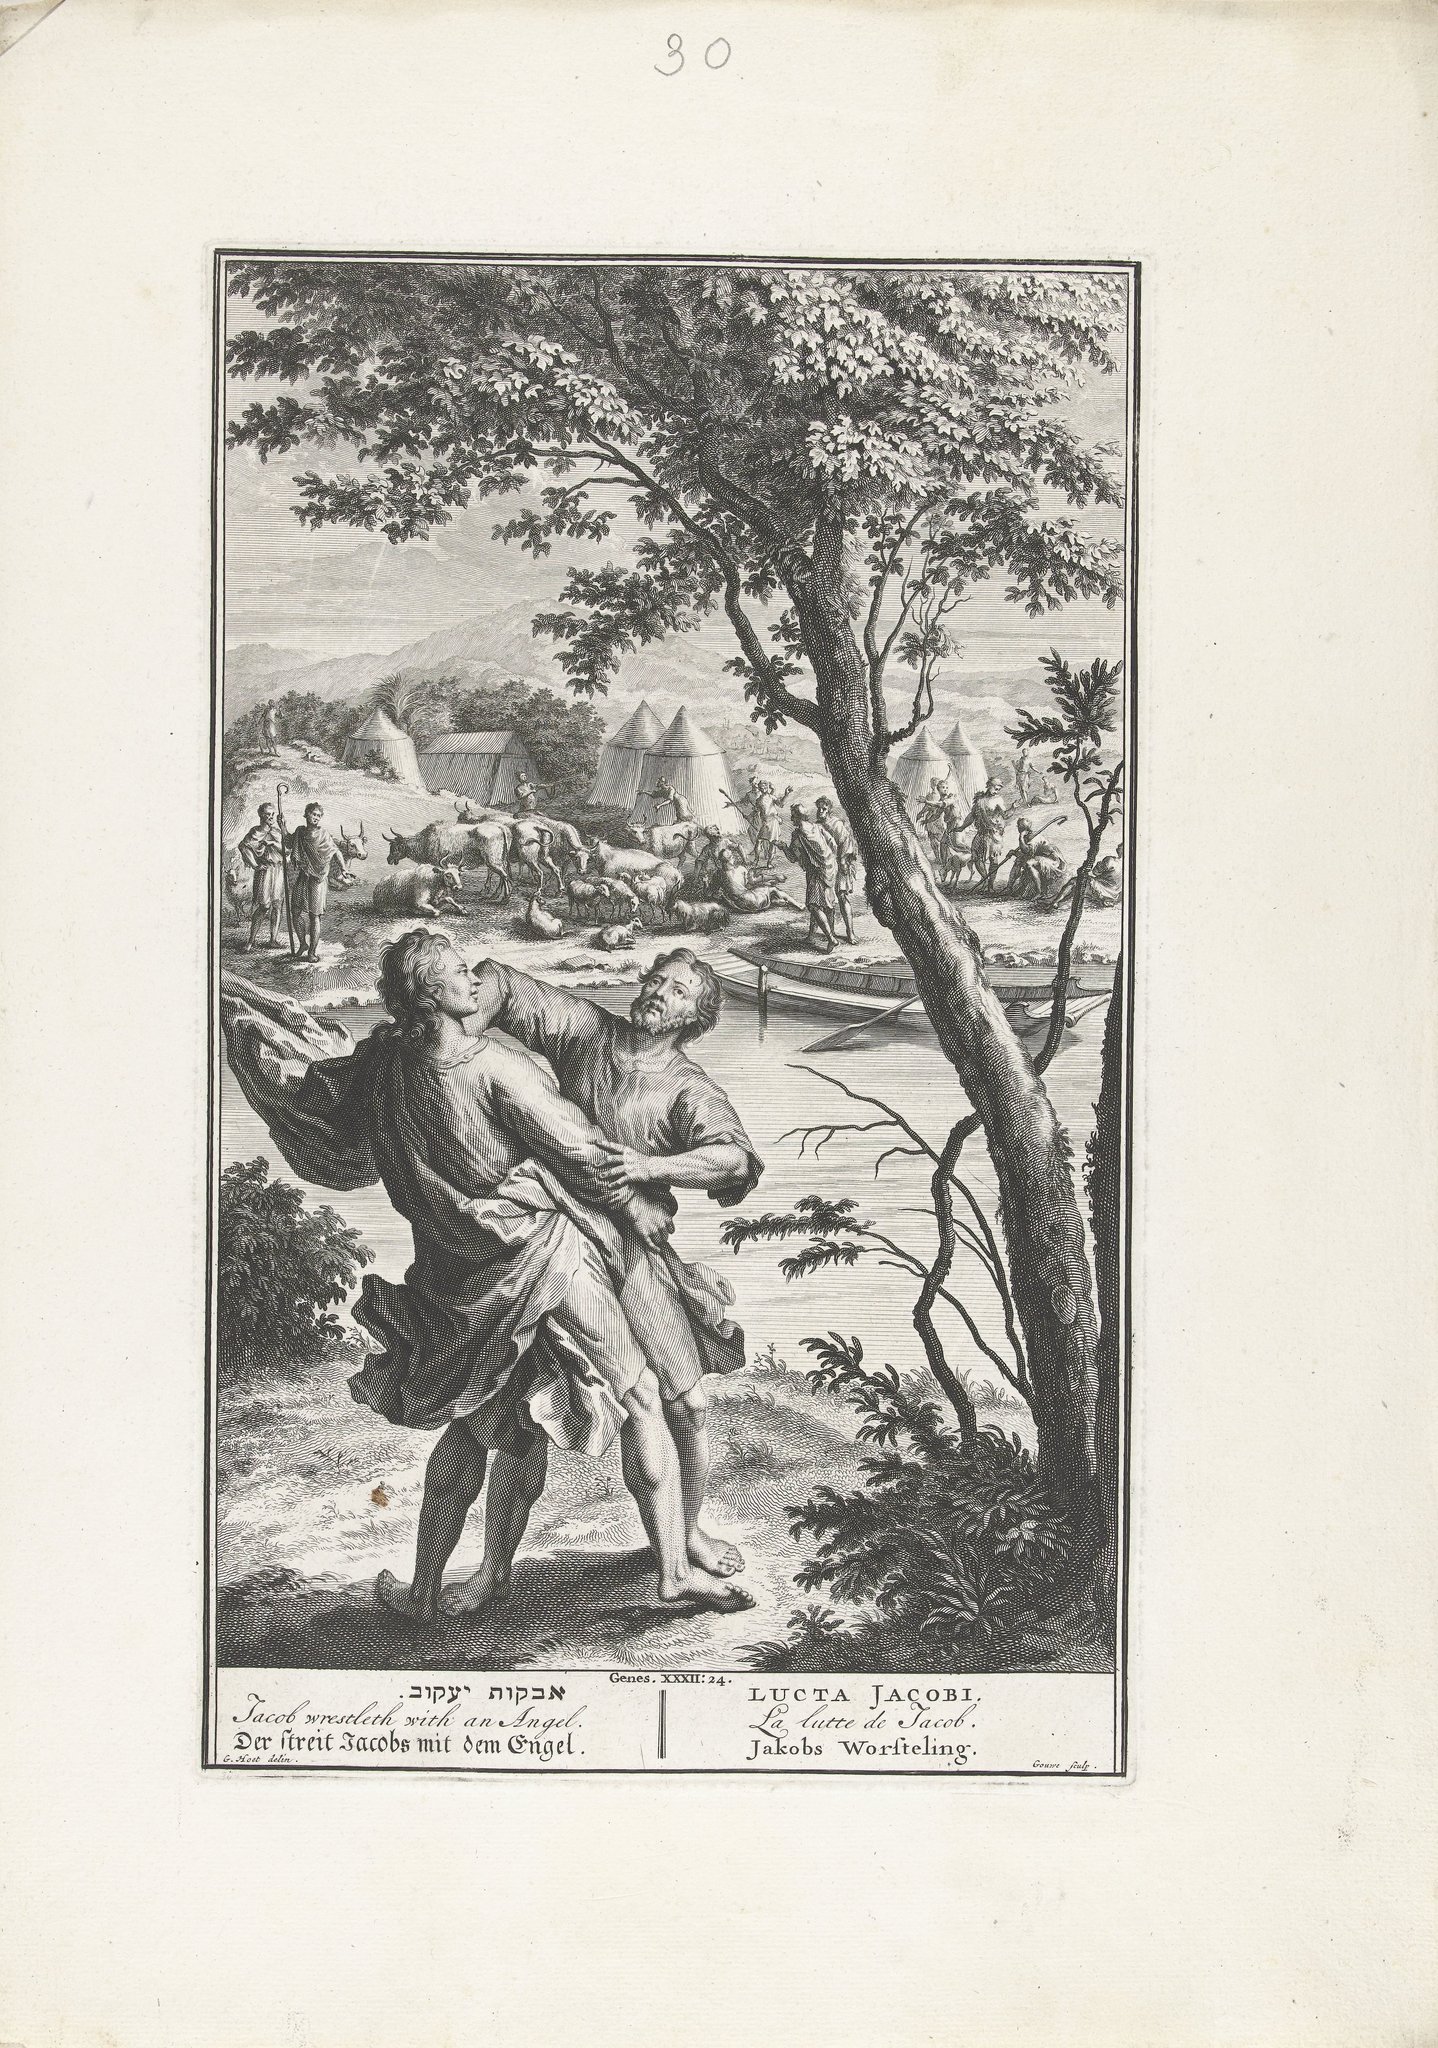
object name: print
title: Jakob worstelt met de engel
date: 1728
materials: paper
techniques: engraving, etching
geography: amsterdam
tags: jacob wrestles with the angel (or man) till daybreak; jacob's thigh is put out of joint, jacob sends his family and caravan across the river jabbok, and stays behind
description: Jakob staat op de voorgrond. Hij worstelt met een engel. Op de achtergrond de rivier Jabbok en Jakobs medereizigers(Gen. 32:24). De prent heeft een Hebreeuws, Latijns, Frans, Engels, Duits en Nederlands onderschrift.